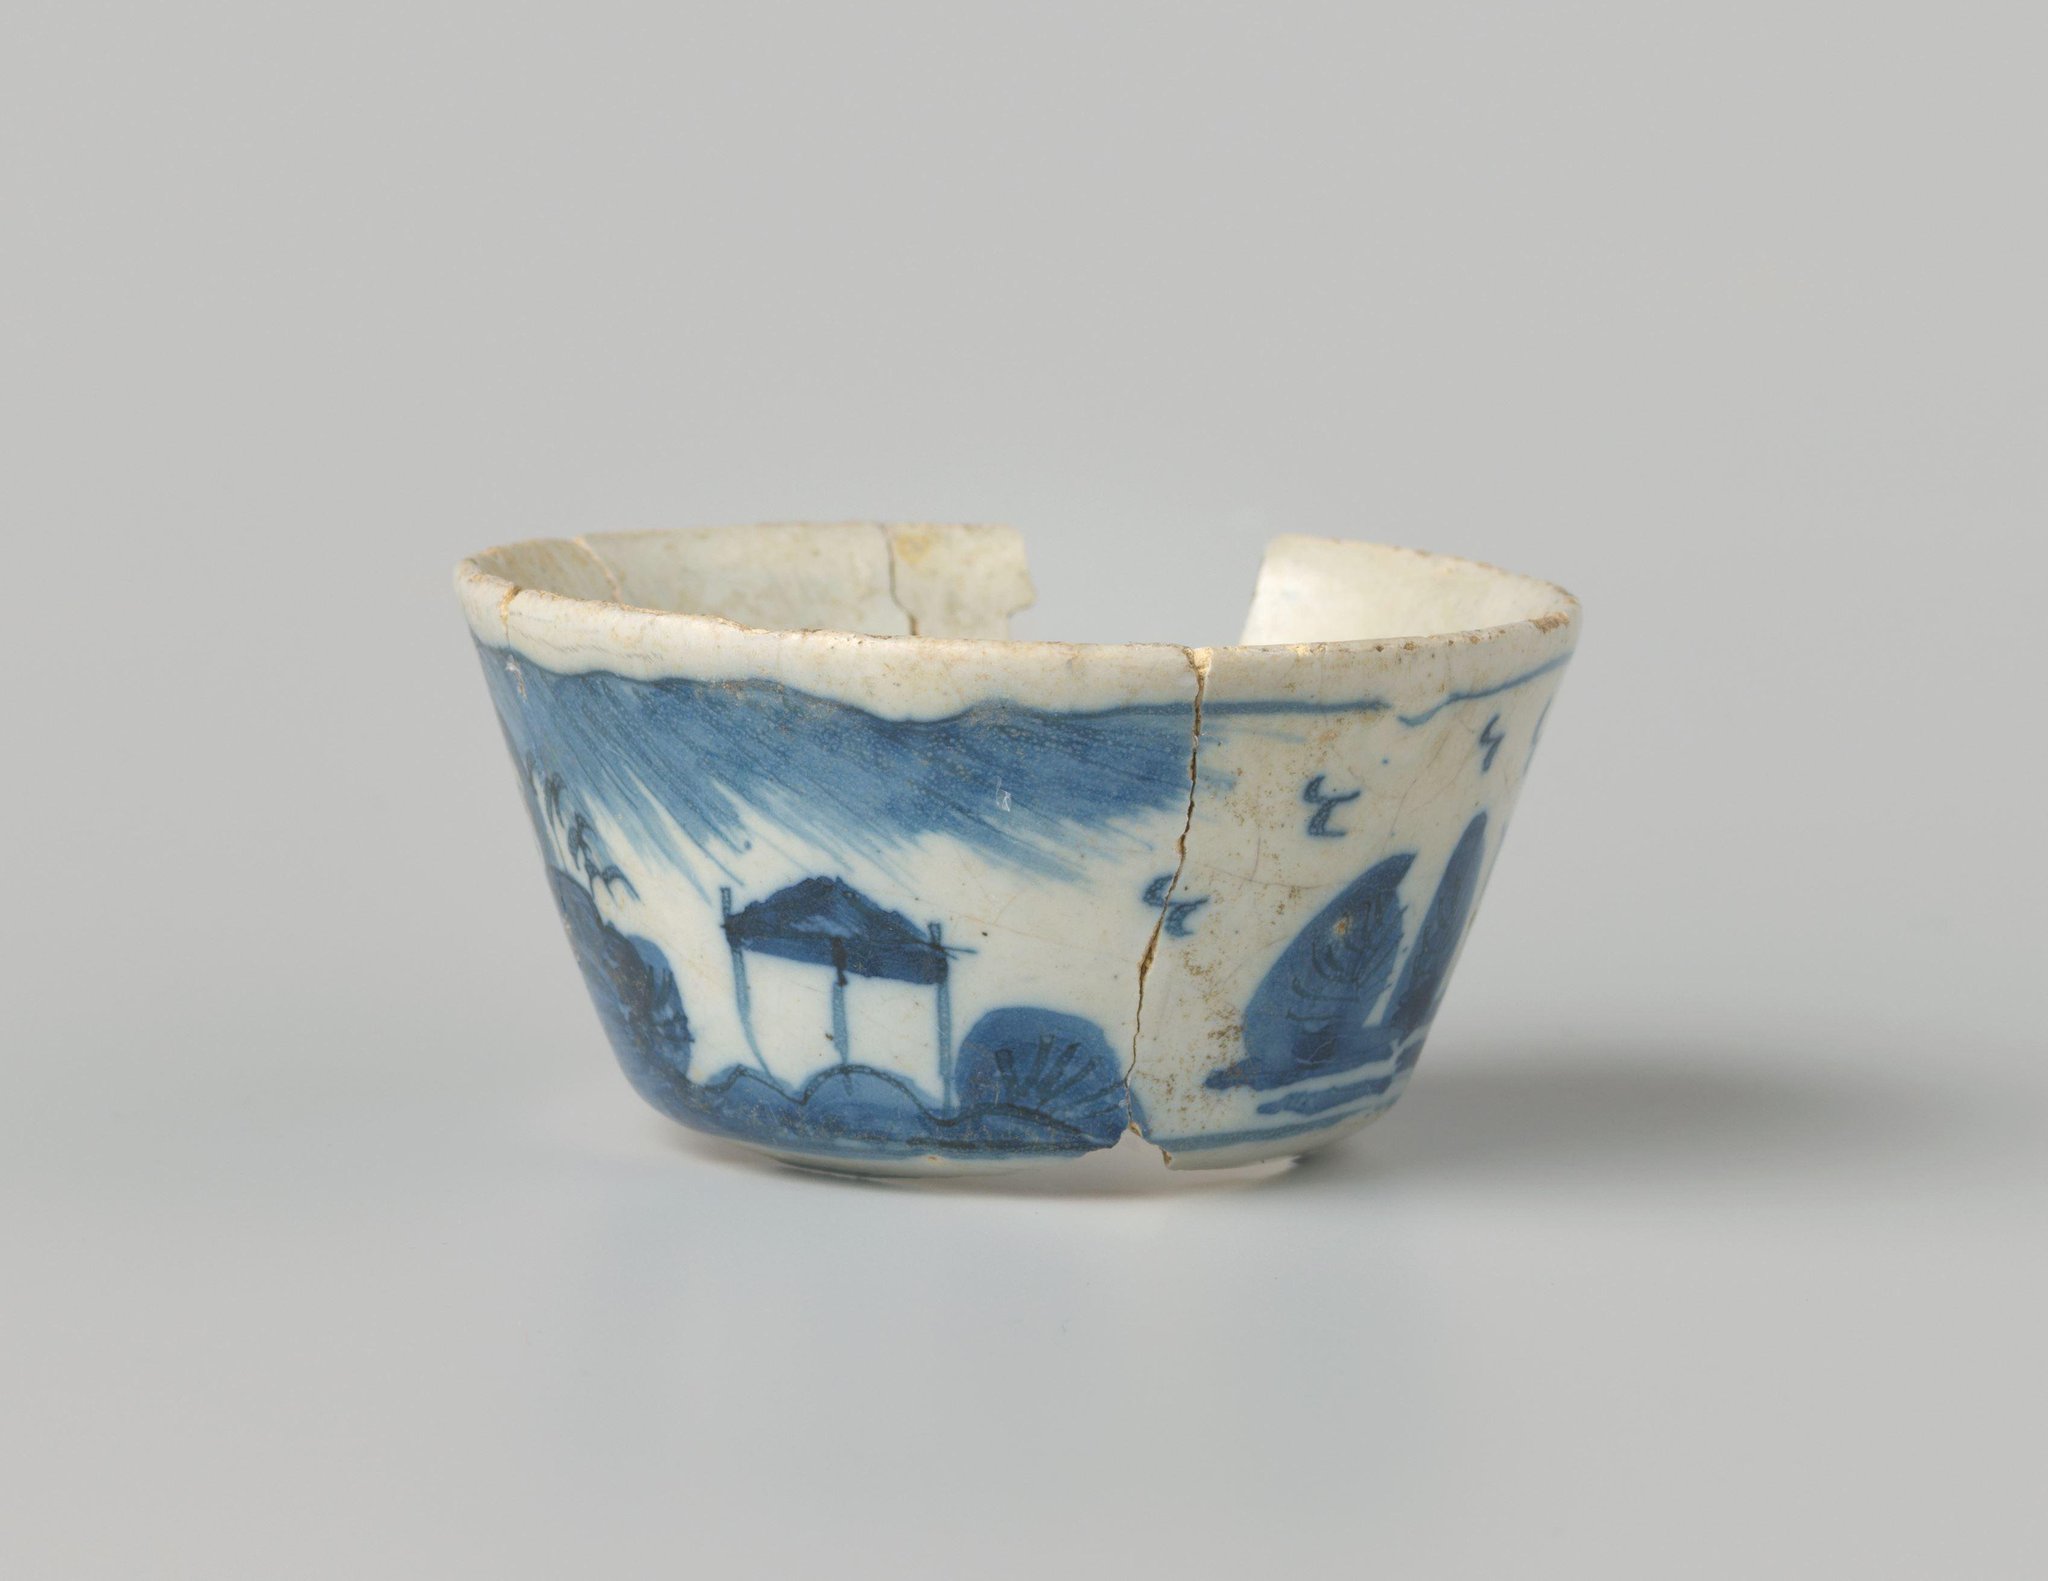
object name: fragment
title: Kop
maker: Anonymous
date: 1660-1730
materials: earthenware, glaze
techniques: painted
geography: delft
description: Kop van blauw beschilderde faience, beschilderd met een rondom lopend landschap met een boot. De kop is een bodemvondst en de bodem ontbreekt.